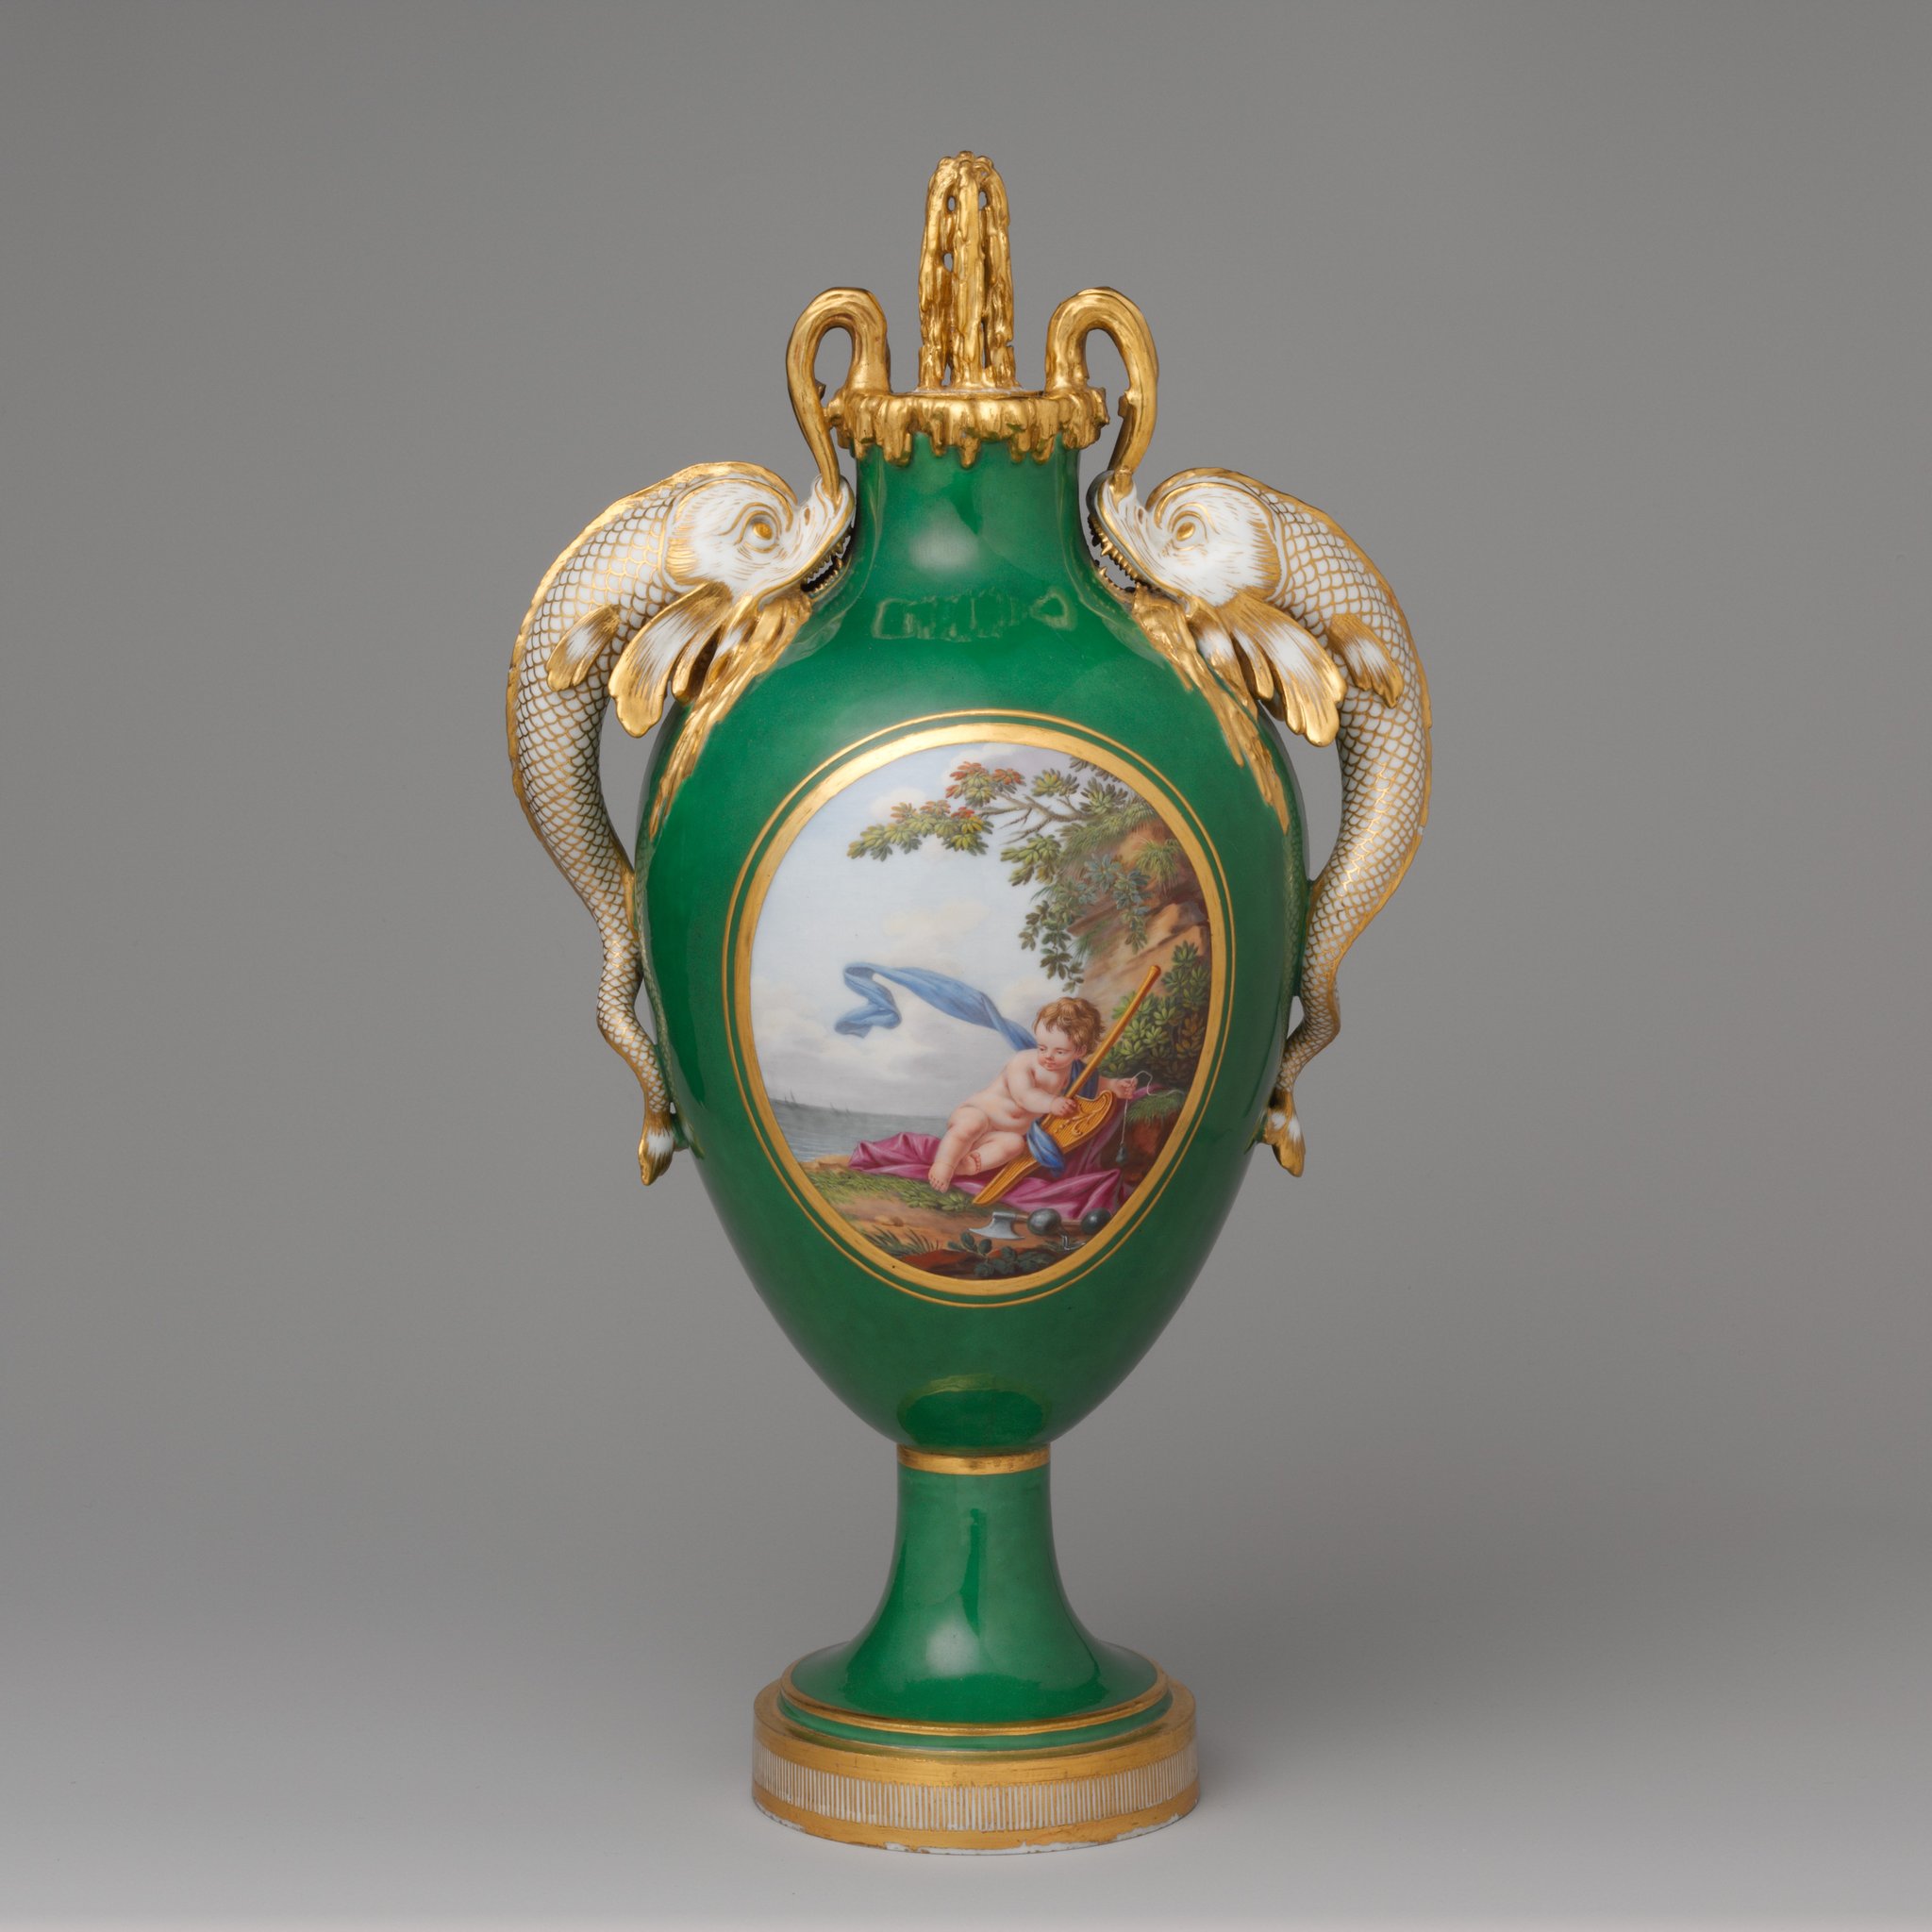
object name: vase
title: Vase with cover (vase à dauphins)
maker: sèvres manufactory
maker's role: manufactory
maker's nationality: french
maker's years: 1740-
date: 1765-1770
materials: soft paste porcelain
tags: musical instruments,infants,fish,landscapes